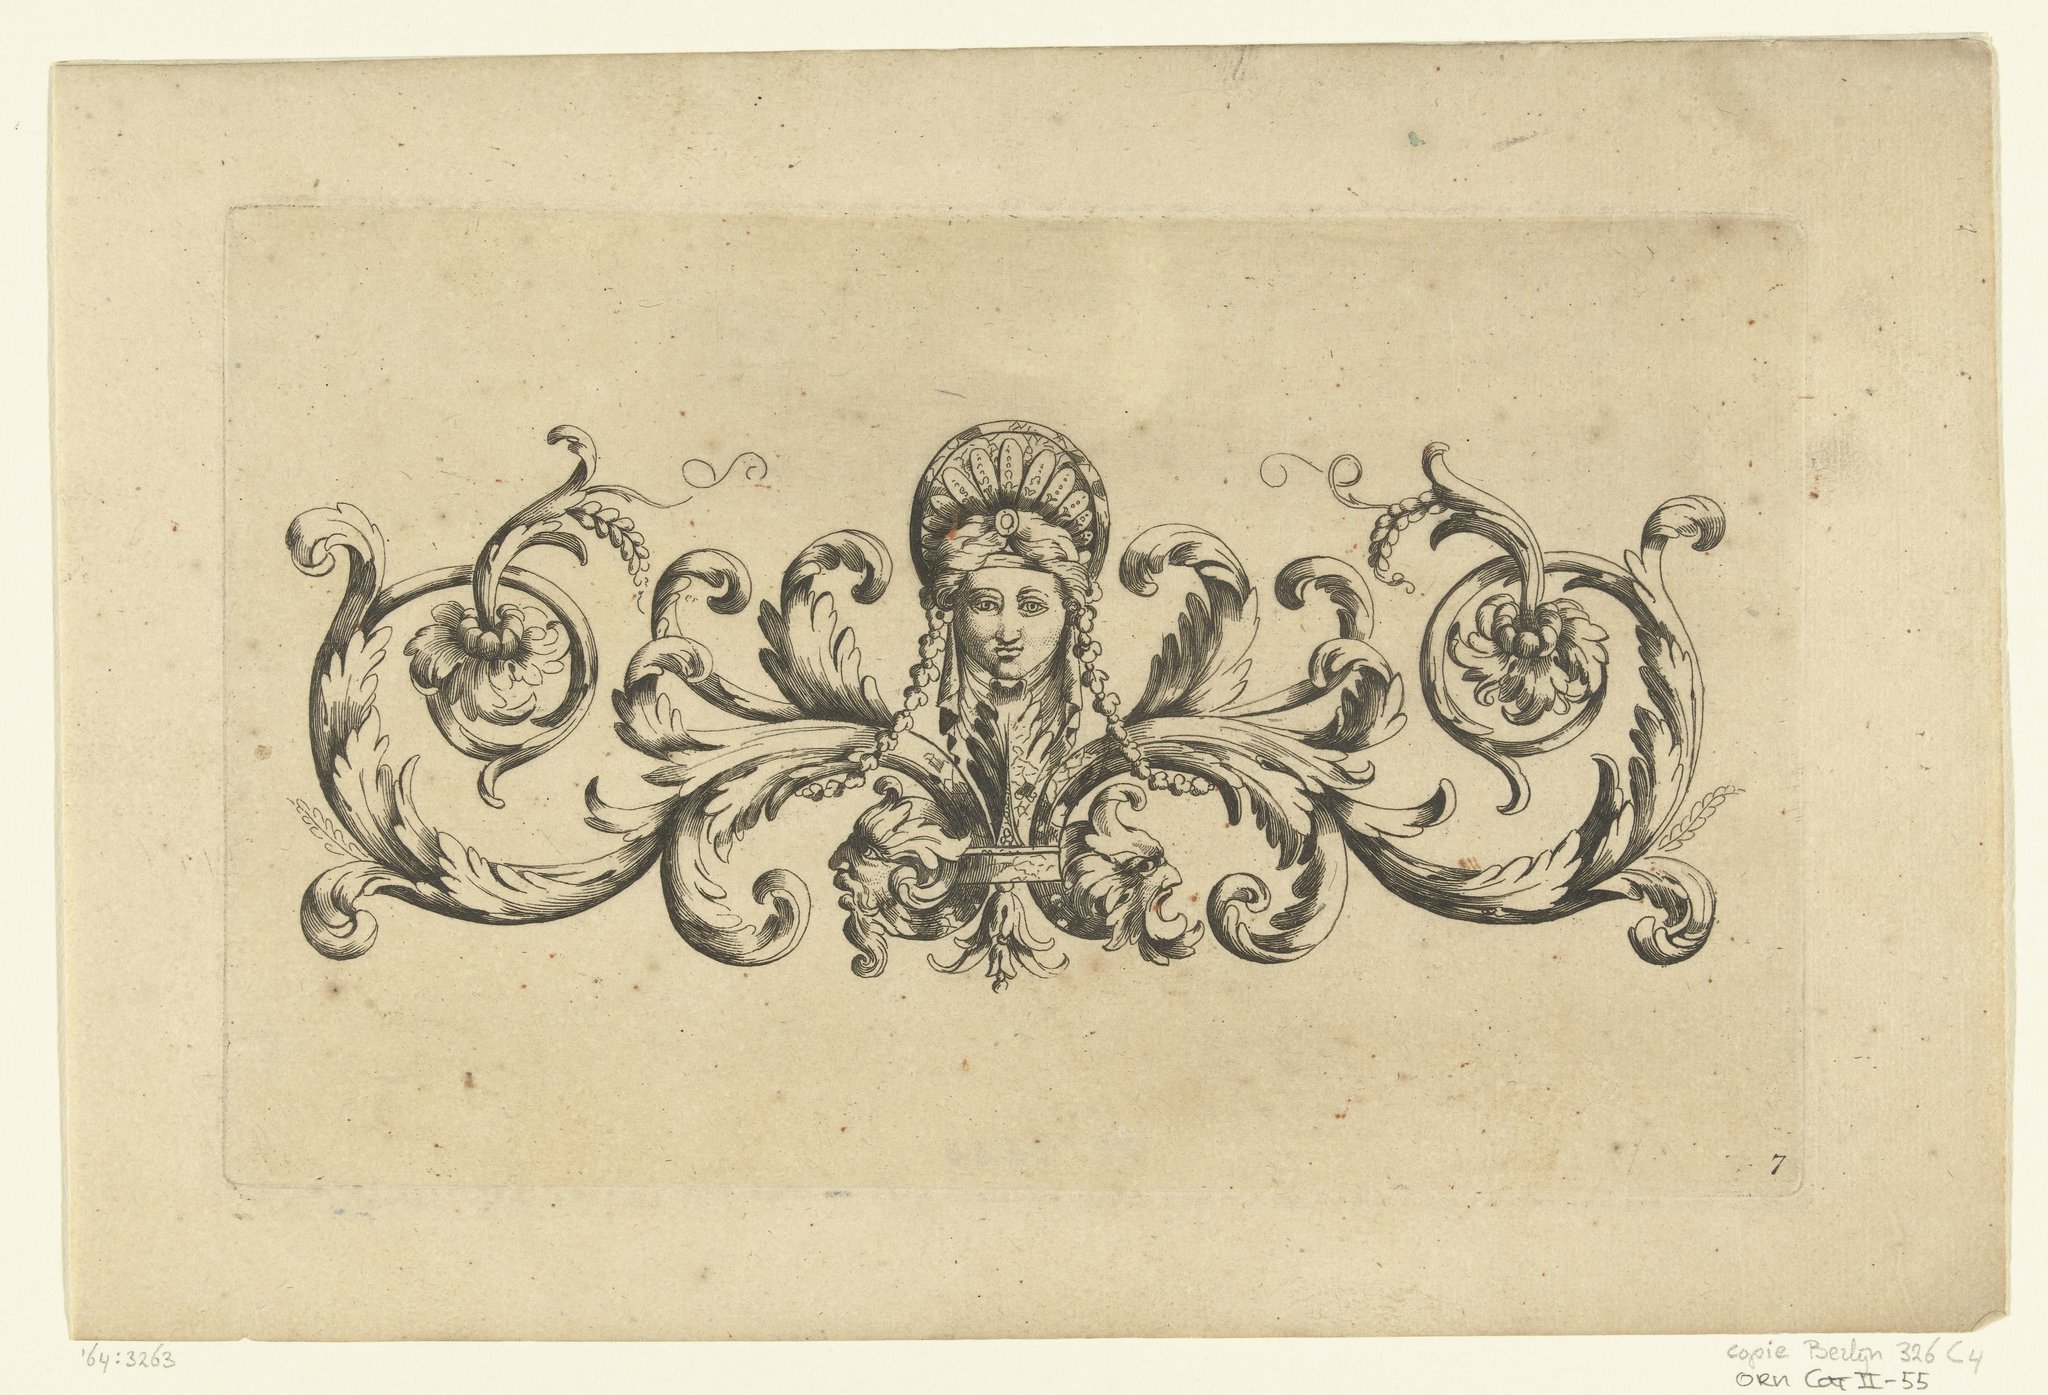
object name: ornament print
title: Ornemens à la Mode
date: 1680-1690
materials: paper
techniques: etching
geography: france